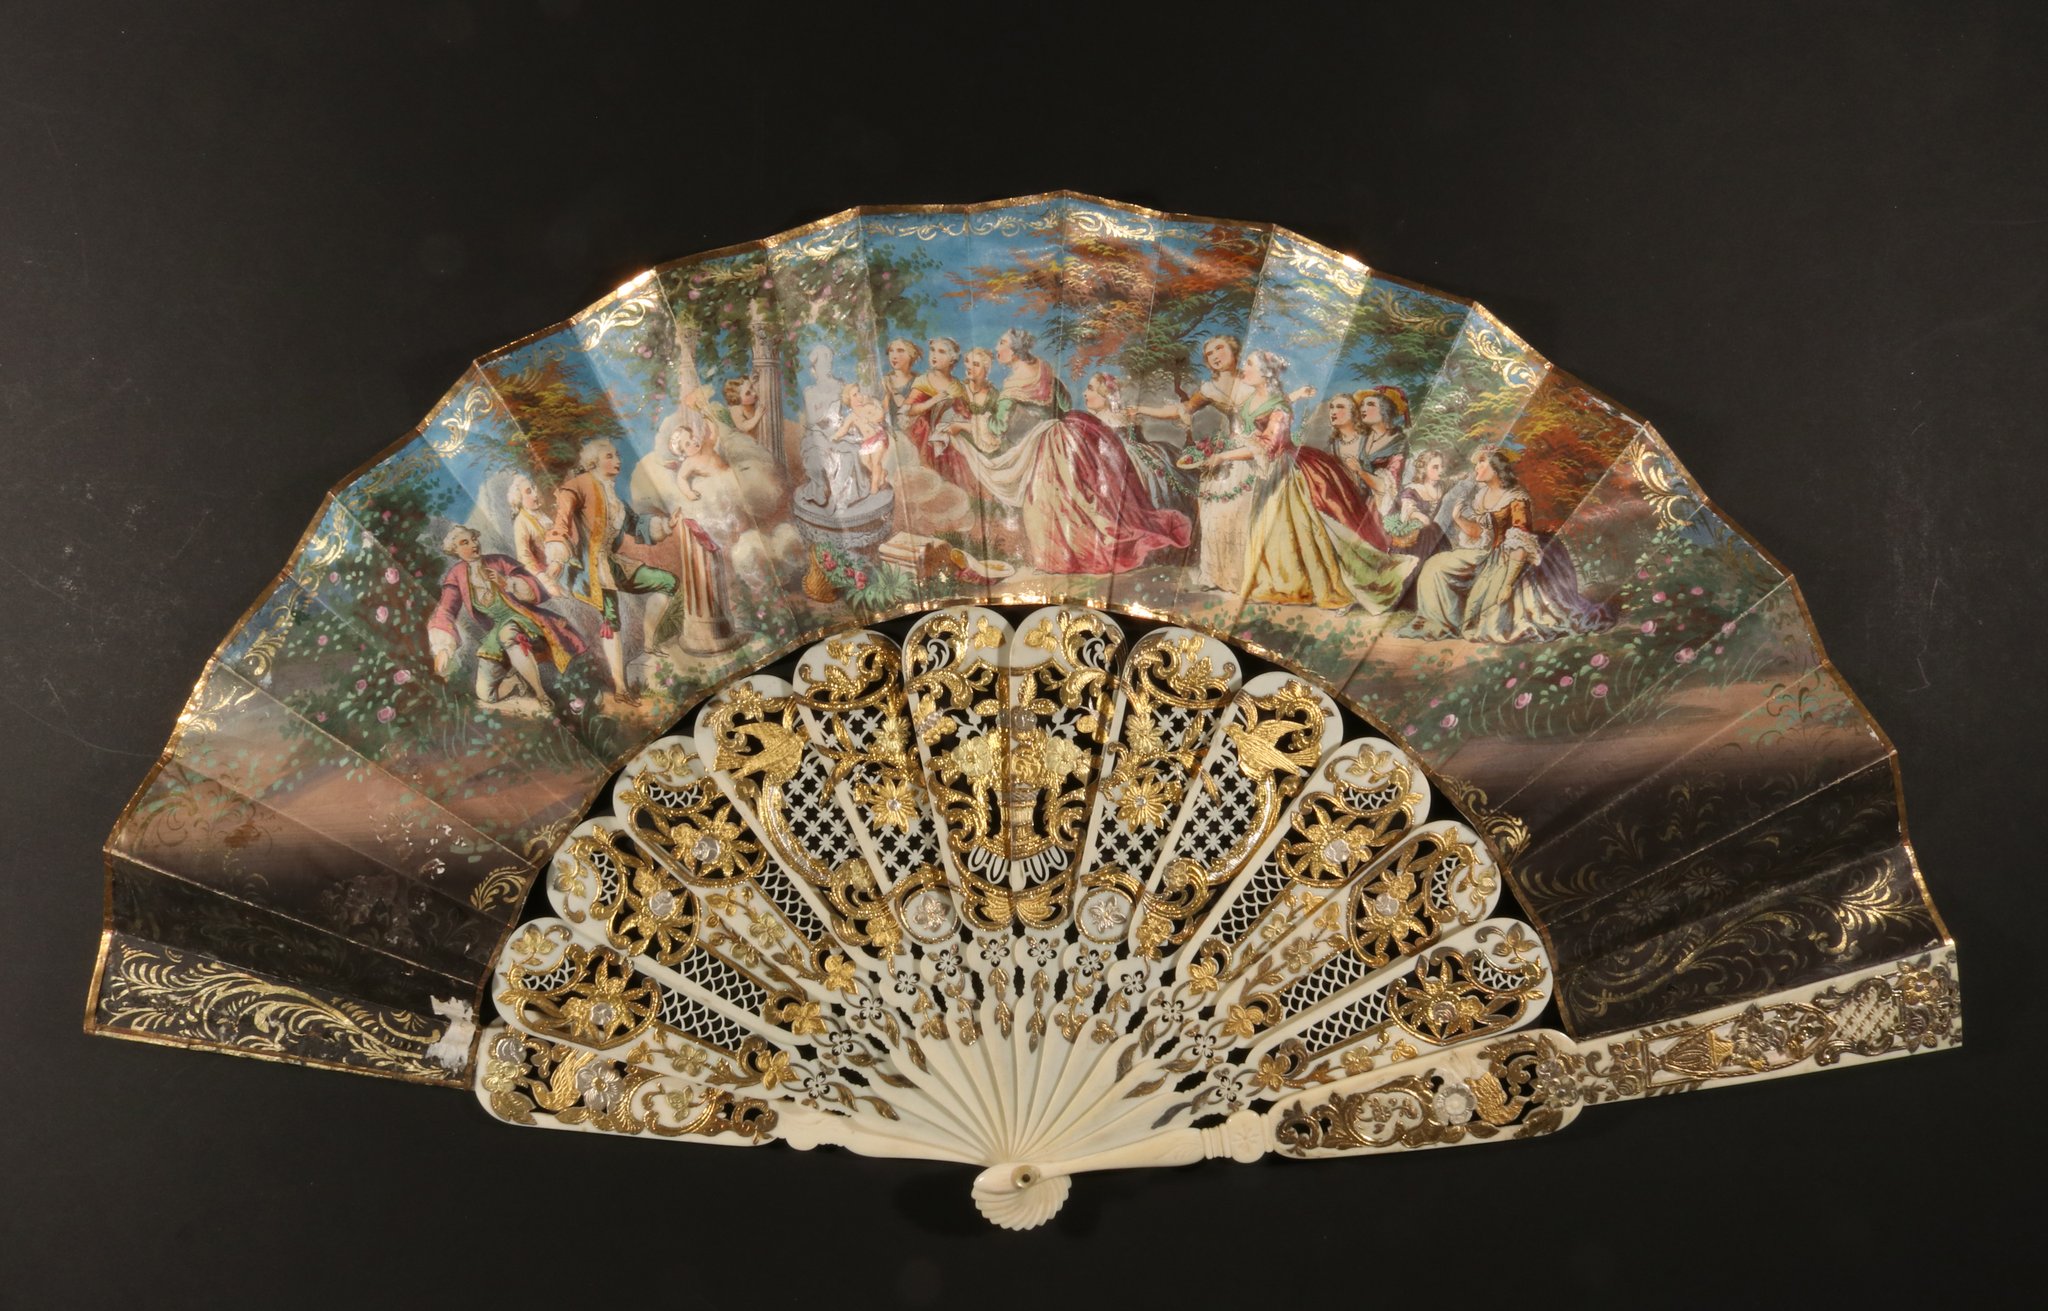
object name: fan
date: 1834-1866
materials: ivory, mother of pearl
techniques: gilding, painting, silvered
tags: men,women